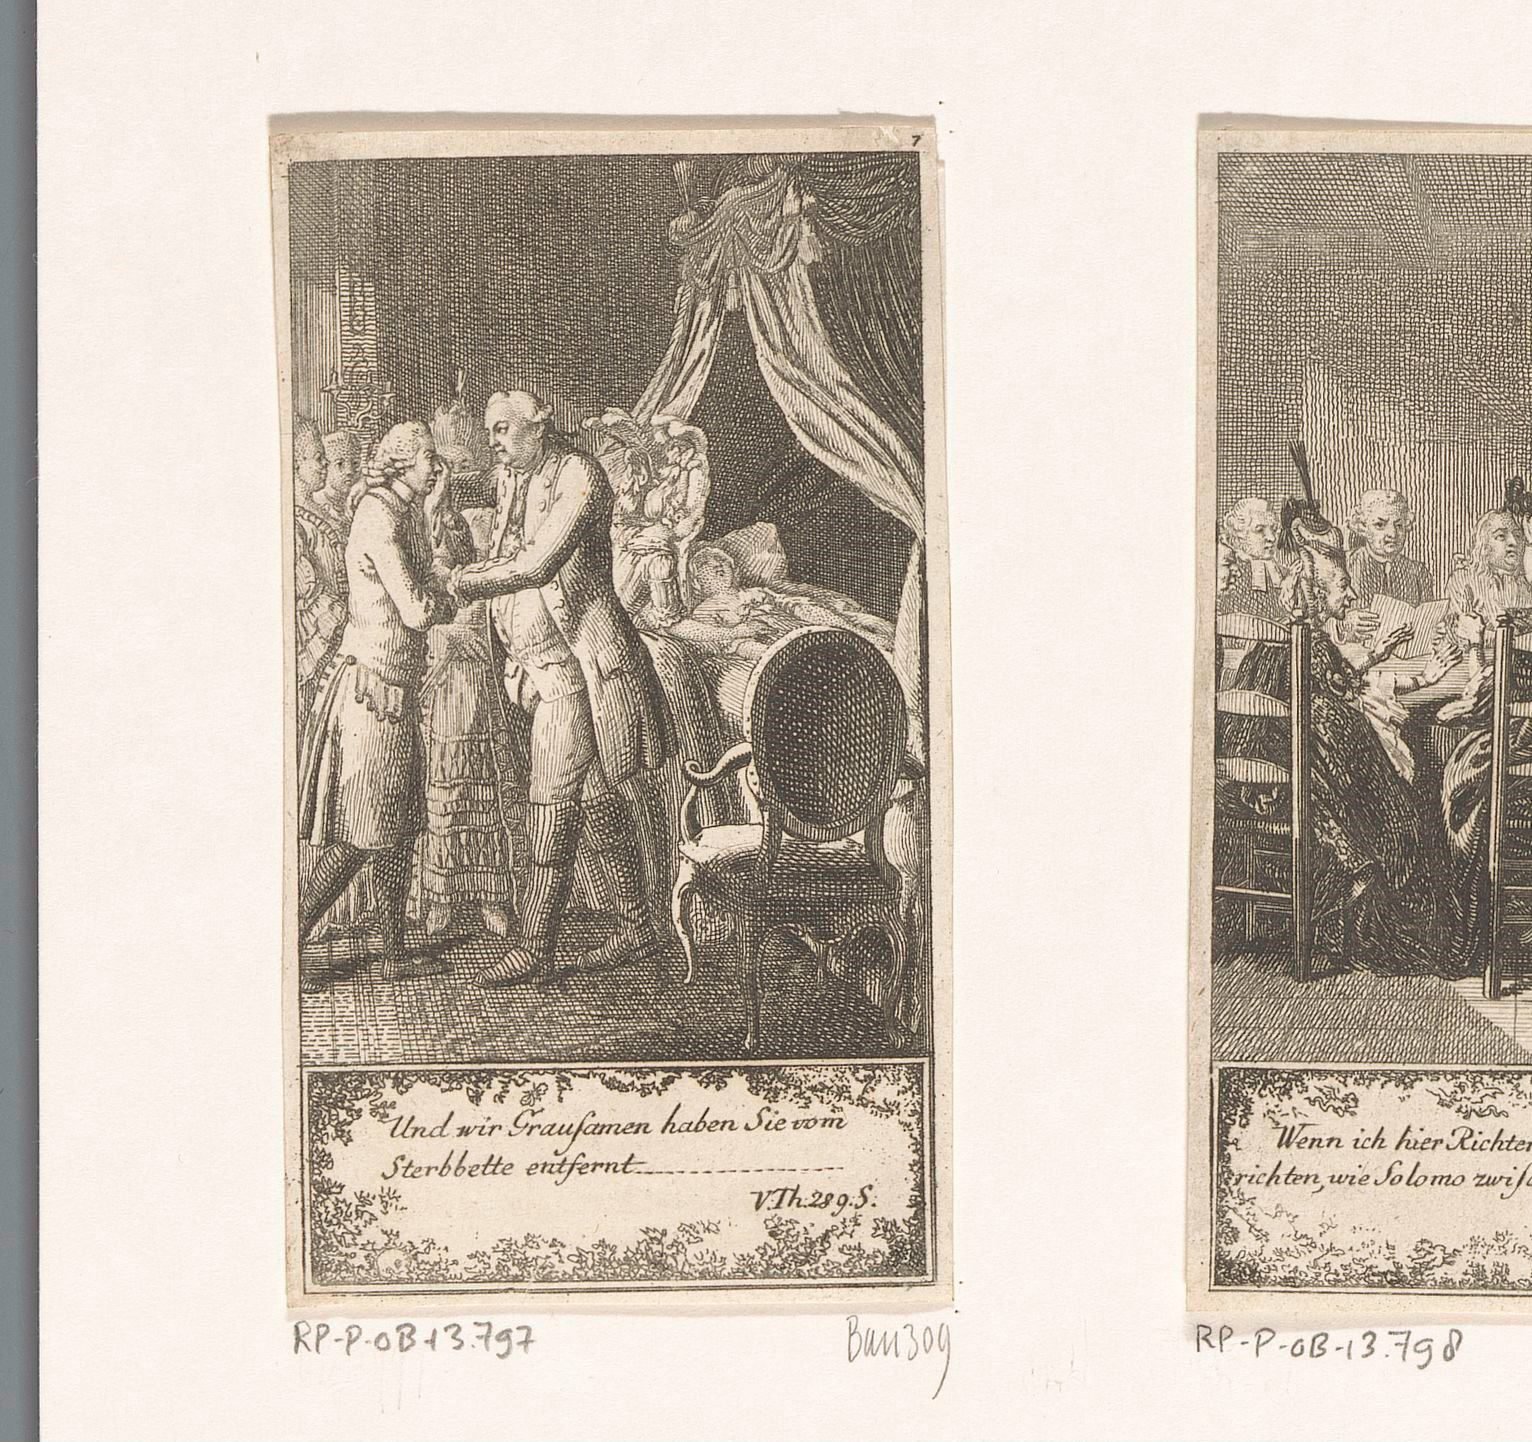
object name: print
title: Vrouw van Pastor Gros op haar doodsbed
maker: daniel nikolaus chodowiecki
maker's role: draughtsman, print maker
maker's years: 1726-1801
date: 1776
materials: paper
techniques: etching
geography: berlin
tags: literature, deathbed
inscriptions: collector's mark: Lugt 2228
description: Zevende scène uit een serie van twaalf scènes die de 'Geschichte des Predigers Gros' illustreren, onderdeel van 'Sophiens Reise von Memel nach Sachsen' door Johann Timotheus Hermes. Pastor Gros von Haberstroh heet eigenlijk Karl Wagner en is de legitieme zoon van Frau E., de pleegmoeder van Sophie. Hij bedient zich ook van het alias Feind. De scènes werden op een plaat geëtst. Deze serie is ook gebruikt in: Gothaischer Hof Kalender zum Nutzen und Vergnügen eingerichtet auf das Jahr 1778. Gotha, C.W. Ettinger, s.a.